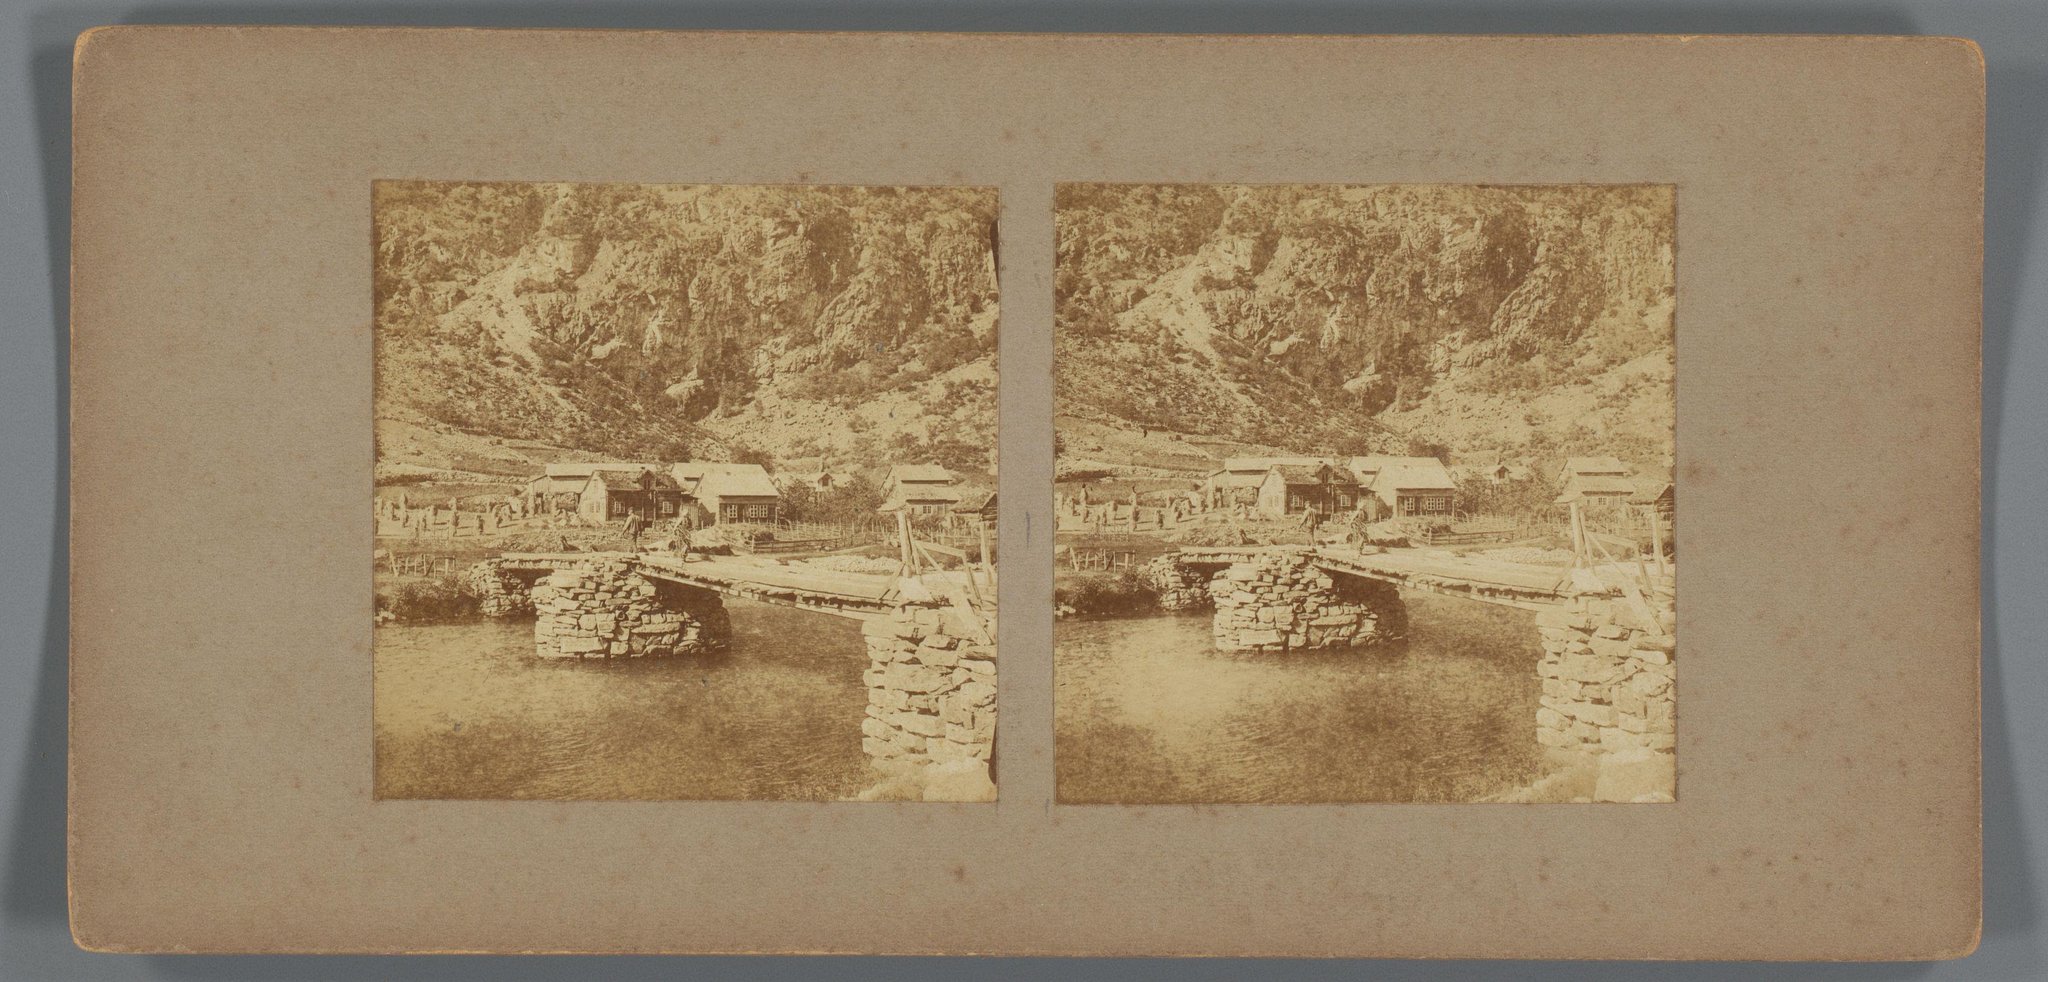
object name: stereograph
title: Gezicht op een brug en een dorp in de Nærøyfjord, Noorwegen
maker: Anonymous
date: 1882-1890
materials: cardboard, photographic support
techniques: gelatin silver print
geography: nærøyfjord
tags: fjord, sea loch, village, bridge